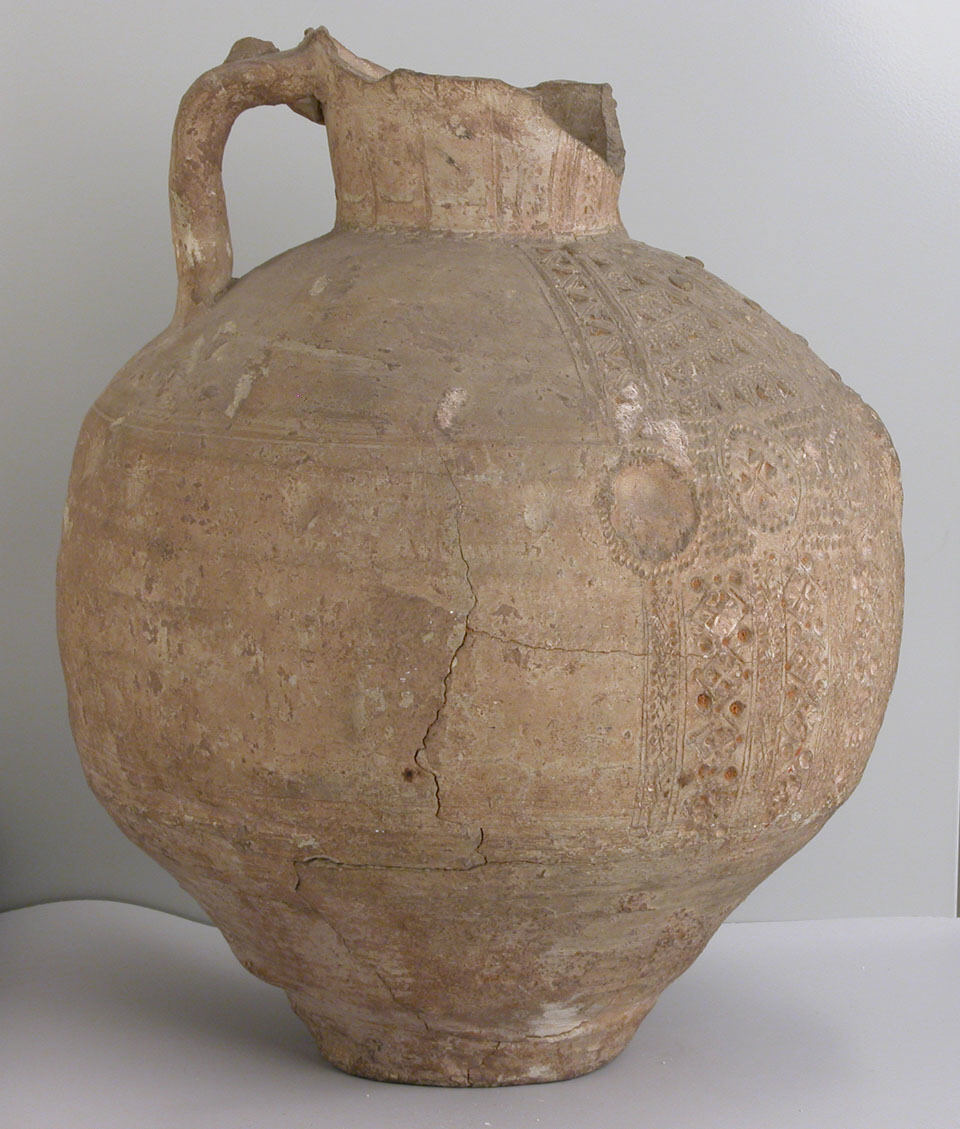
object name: jar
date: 1001-1100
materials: earthenware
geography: syria